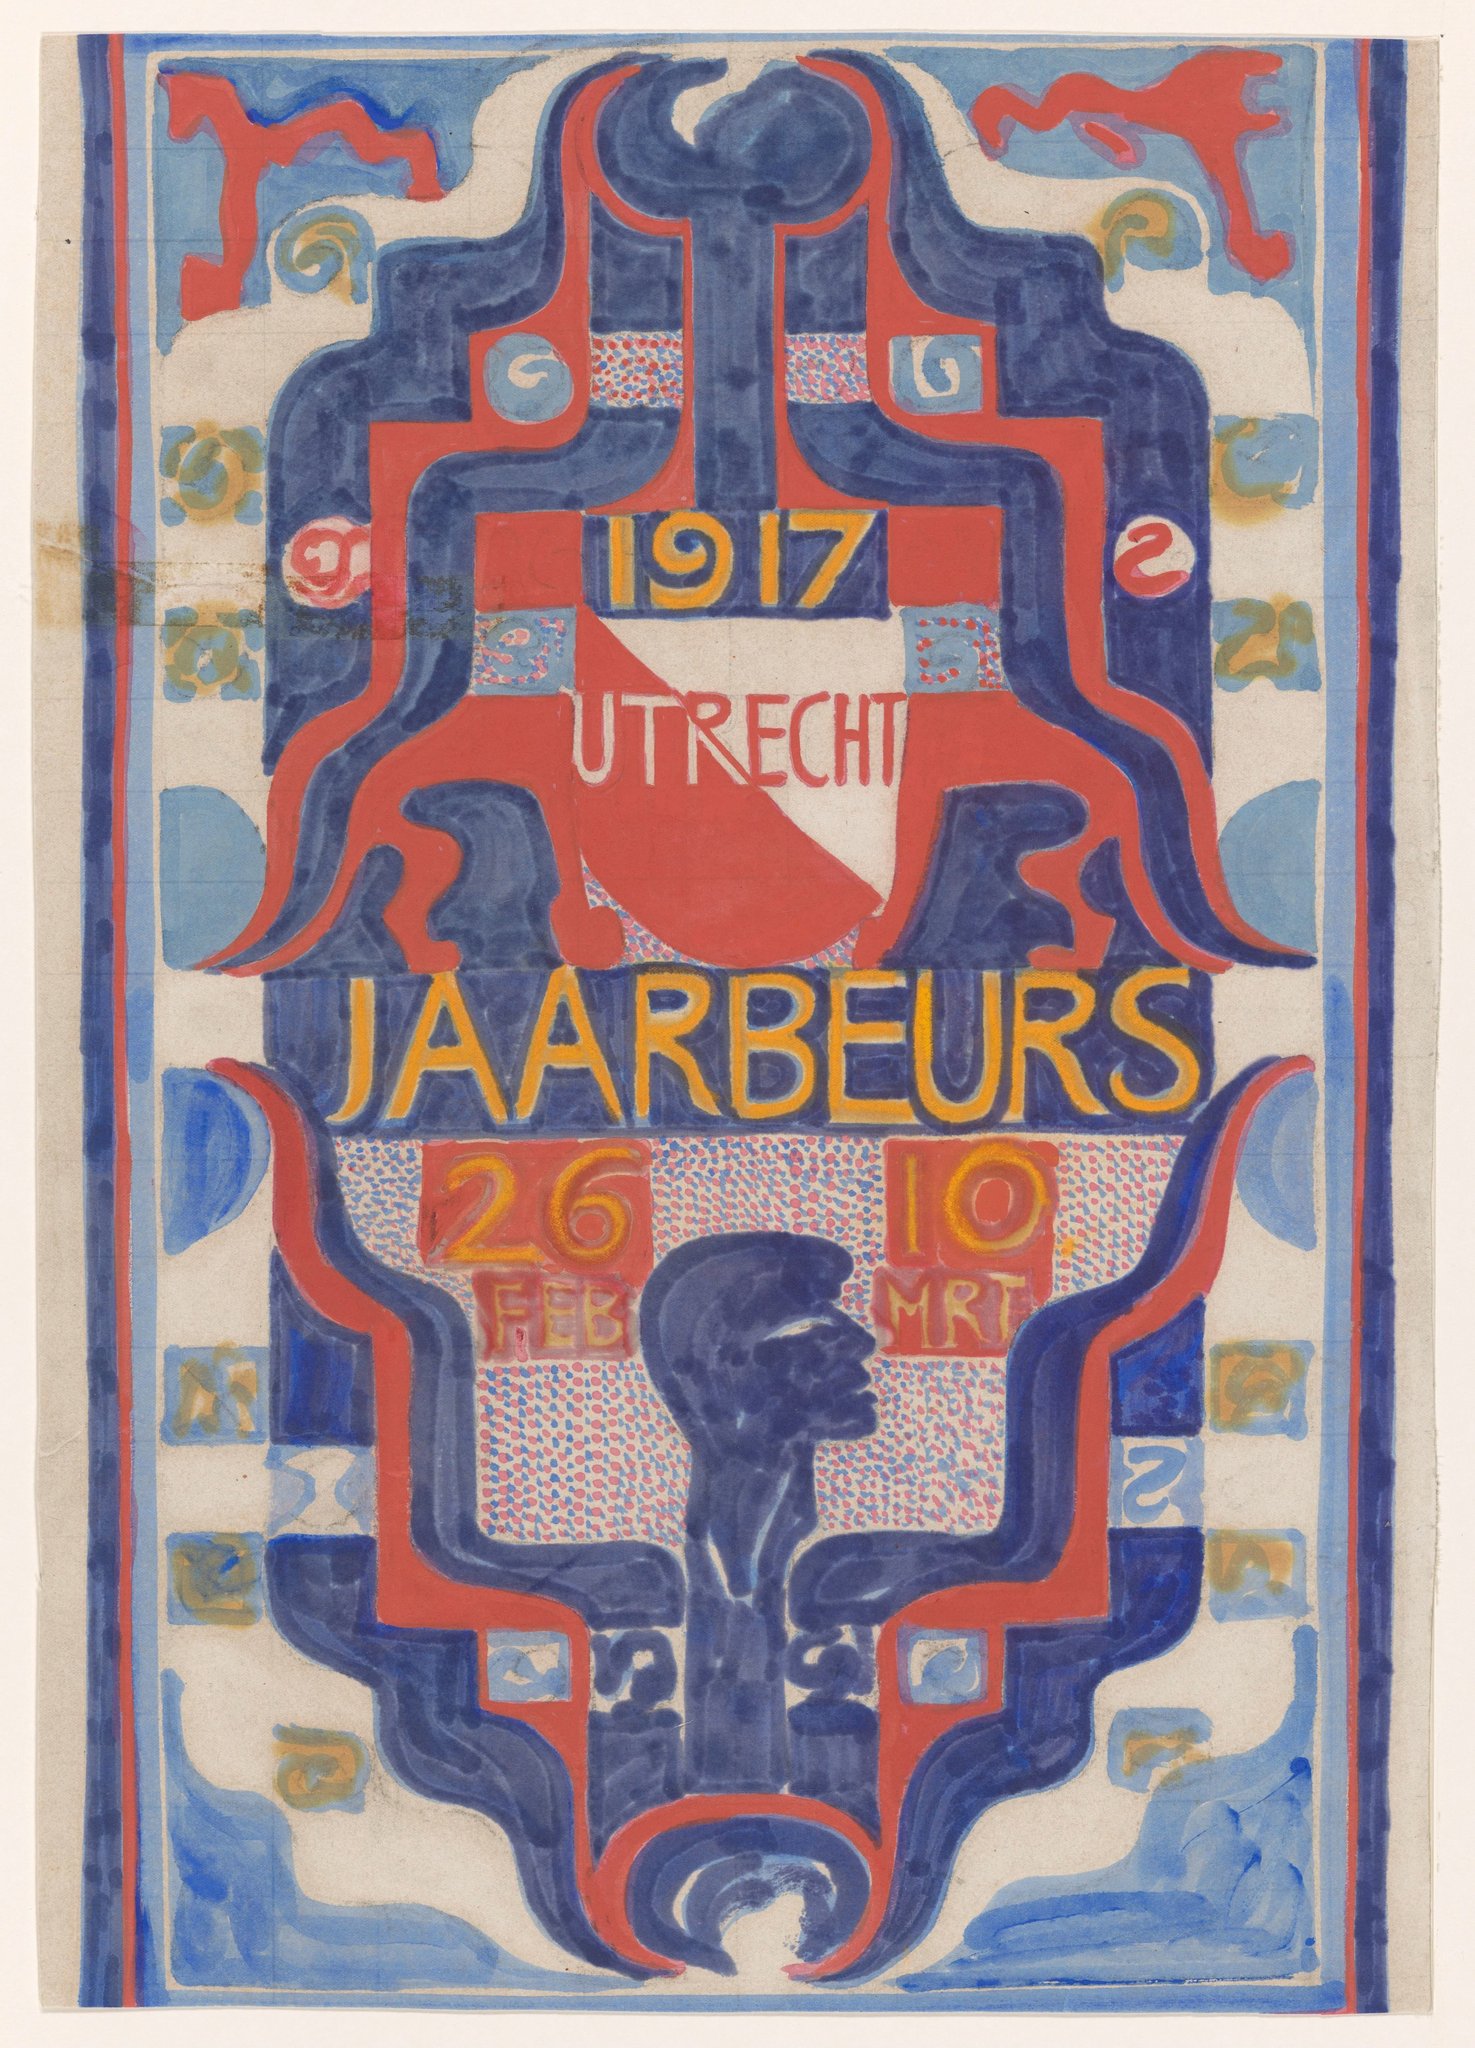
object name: drawing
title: Ontwerp voor een affiche voor de Jaarbeurs te Utrecht in 1917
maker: carel adolph lion cachet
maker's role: draughtsman, print maker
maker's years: 1864-1945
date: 1874-1917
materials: paper, pencil, watercolor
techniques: brush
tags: (annual) fair, trade fair, poster, historical events and situations